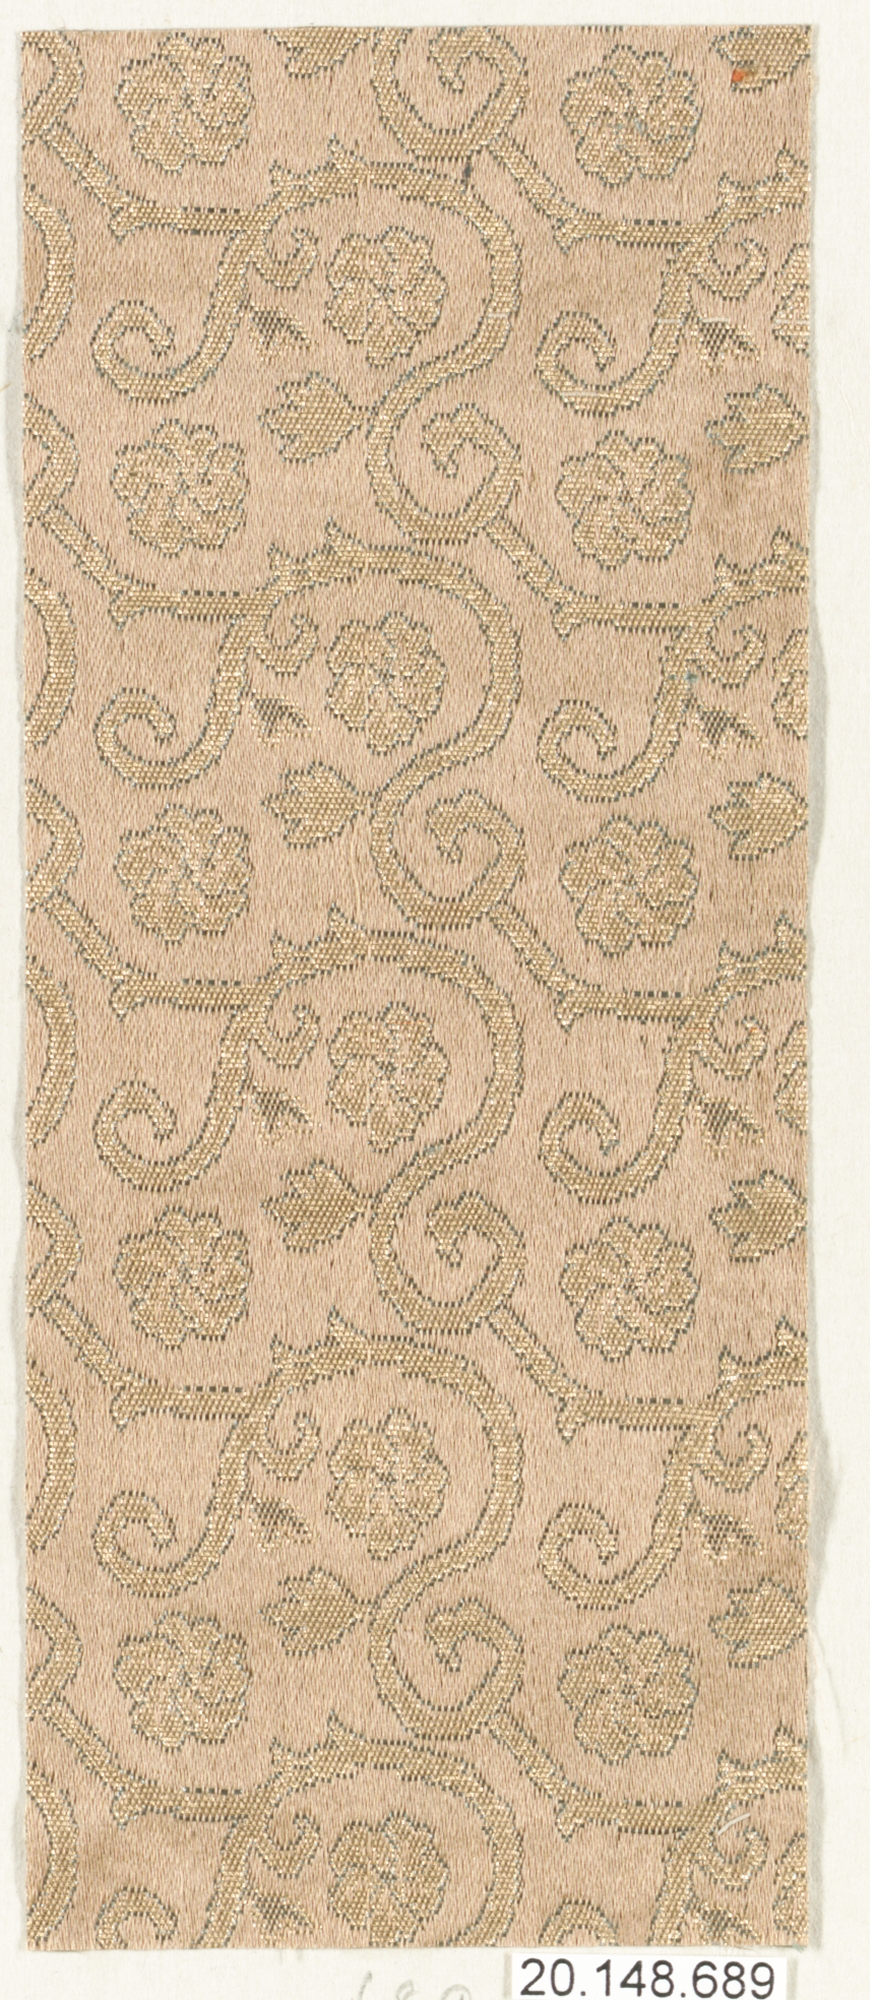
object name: piece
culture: japanese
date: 1701-1800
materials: silk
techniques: compound weave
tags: flowers